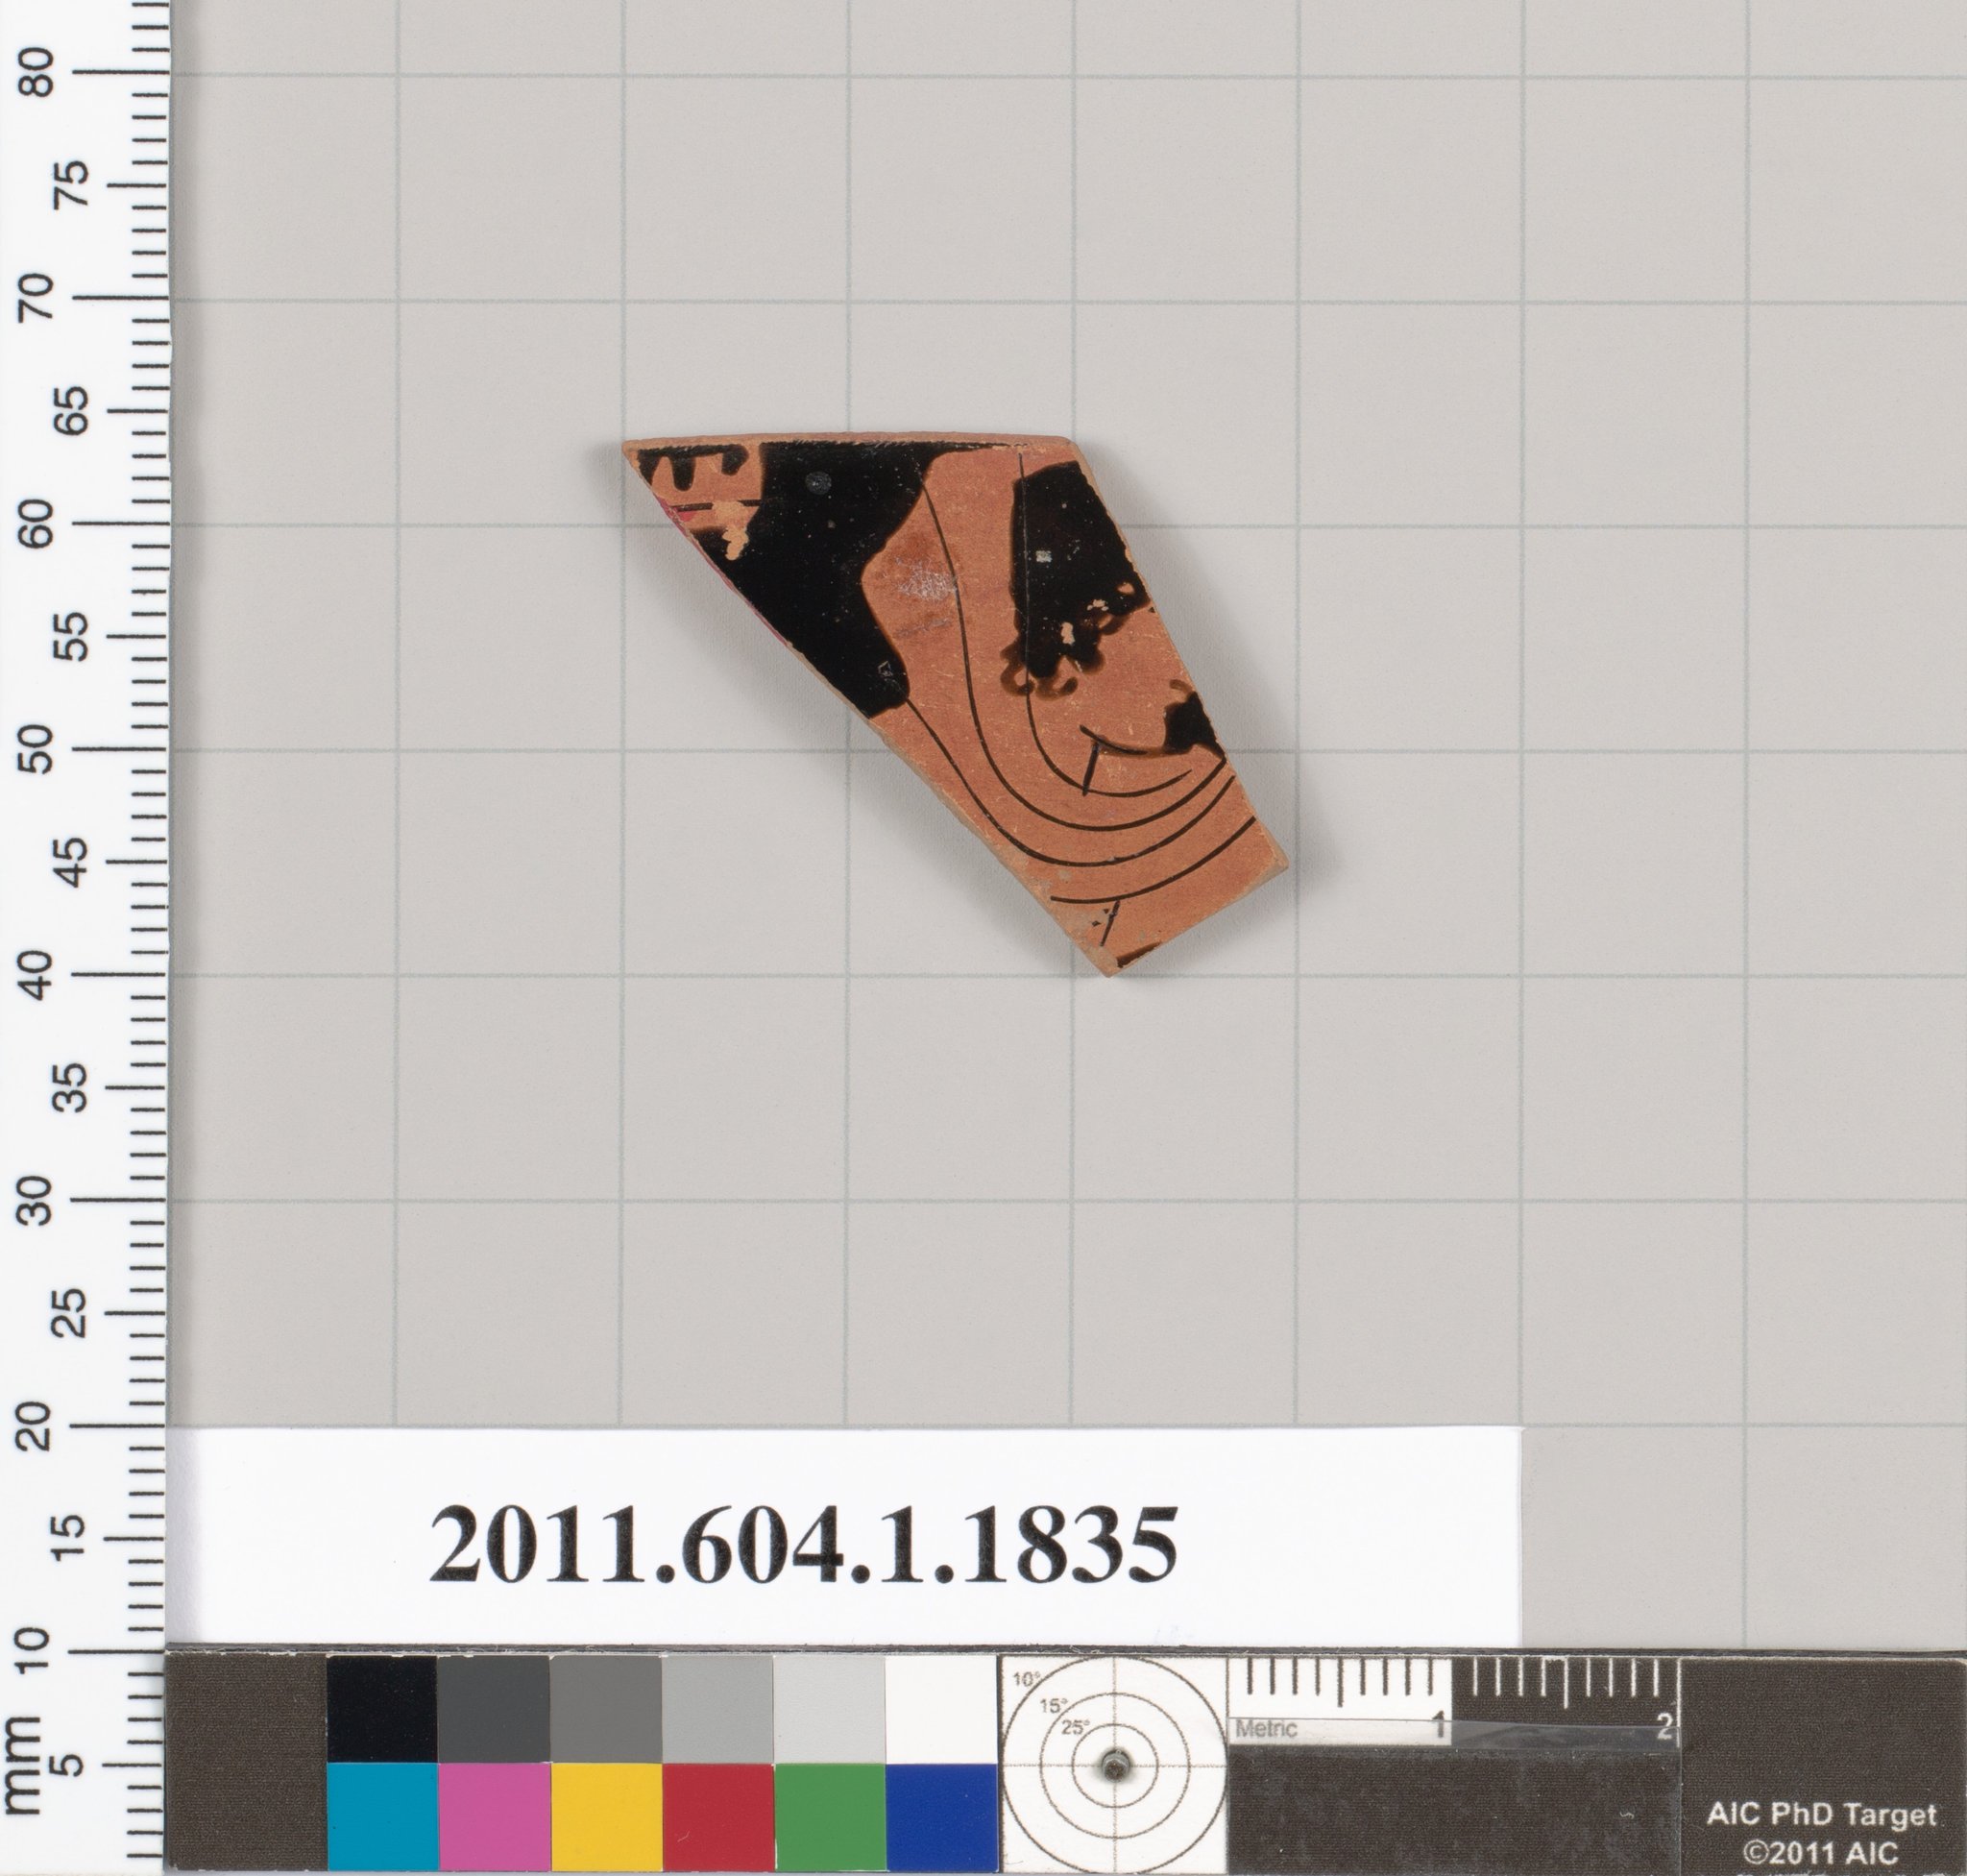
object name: kylix fragment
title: Terracotta rim fragment of a kylix (drinking cup)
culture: greek, attic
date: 470-450 BCE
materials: terracotta